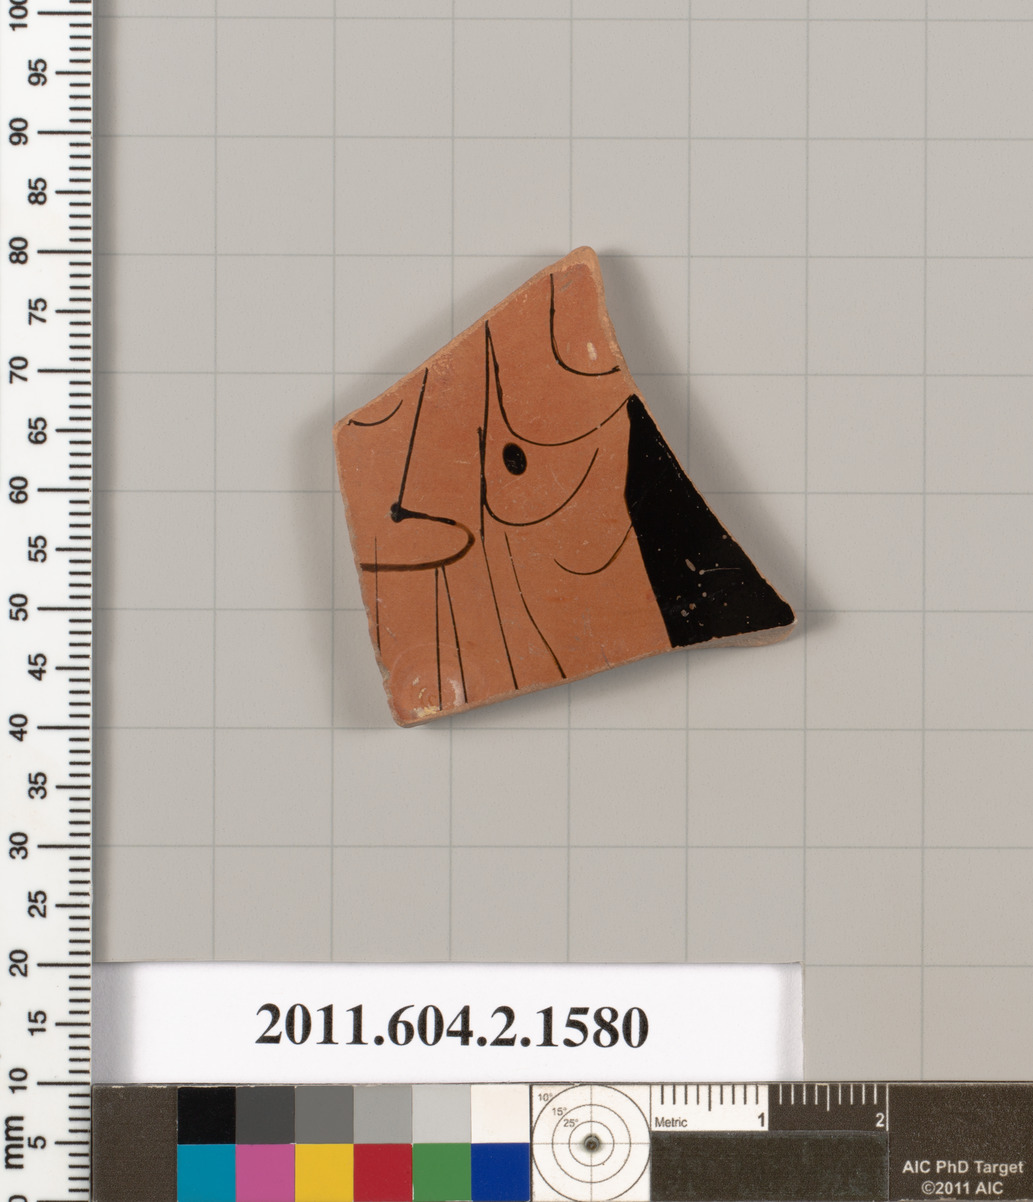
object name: skyphos fragment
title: Terracotta fragment of a skyphos (deep drinking cup)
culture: greek, attic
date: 460-440 BCE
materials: terracotta